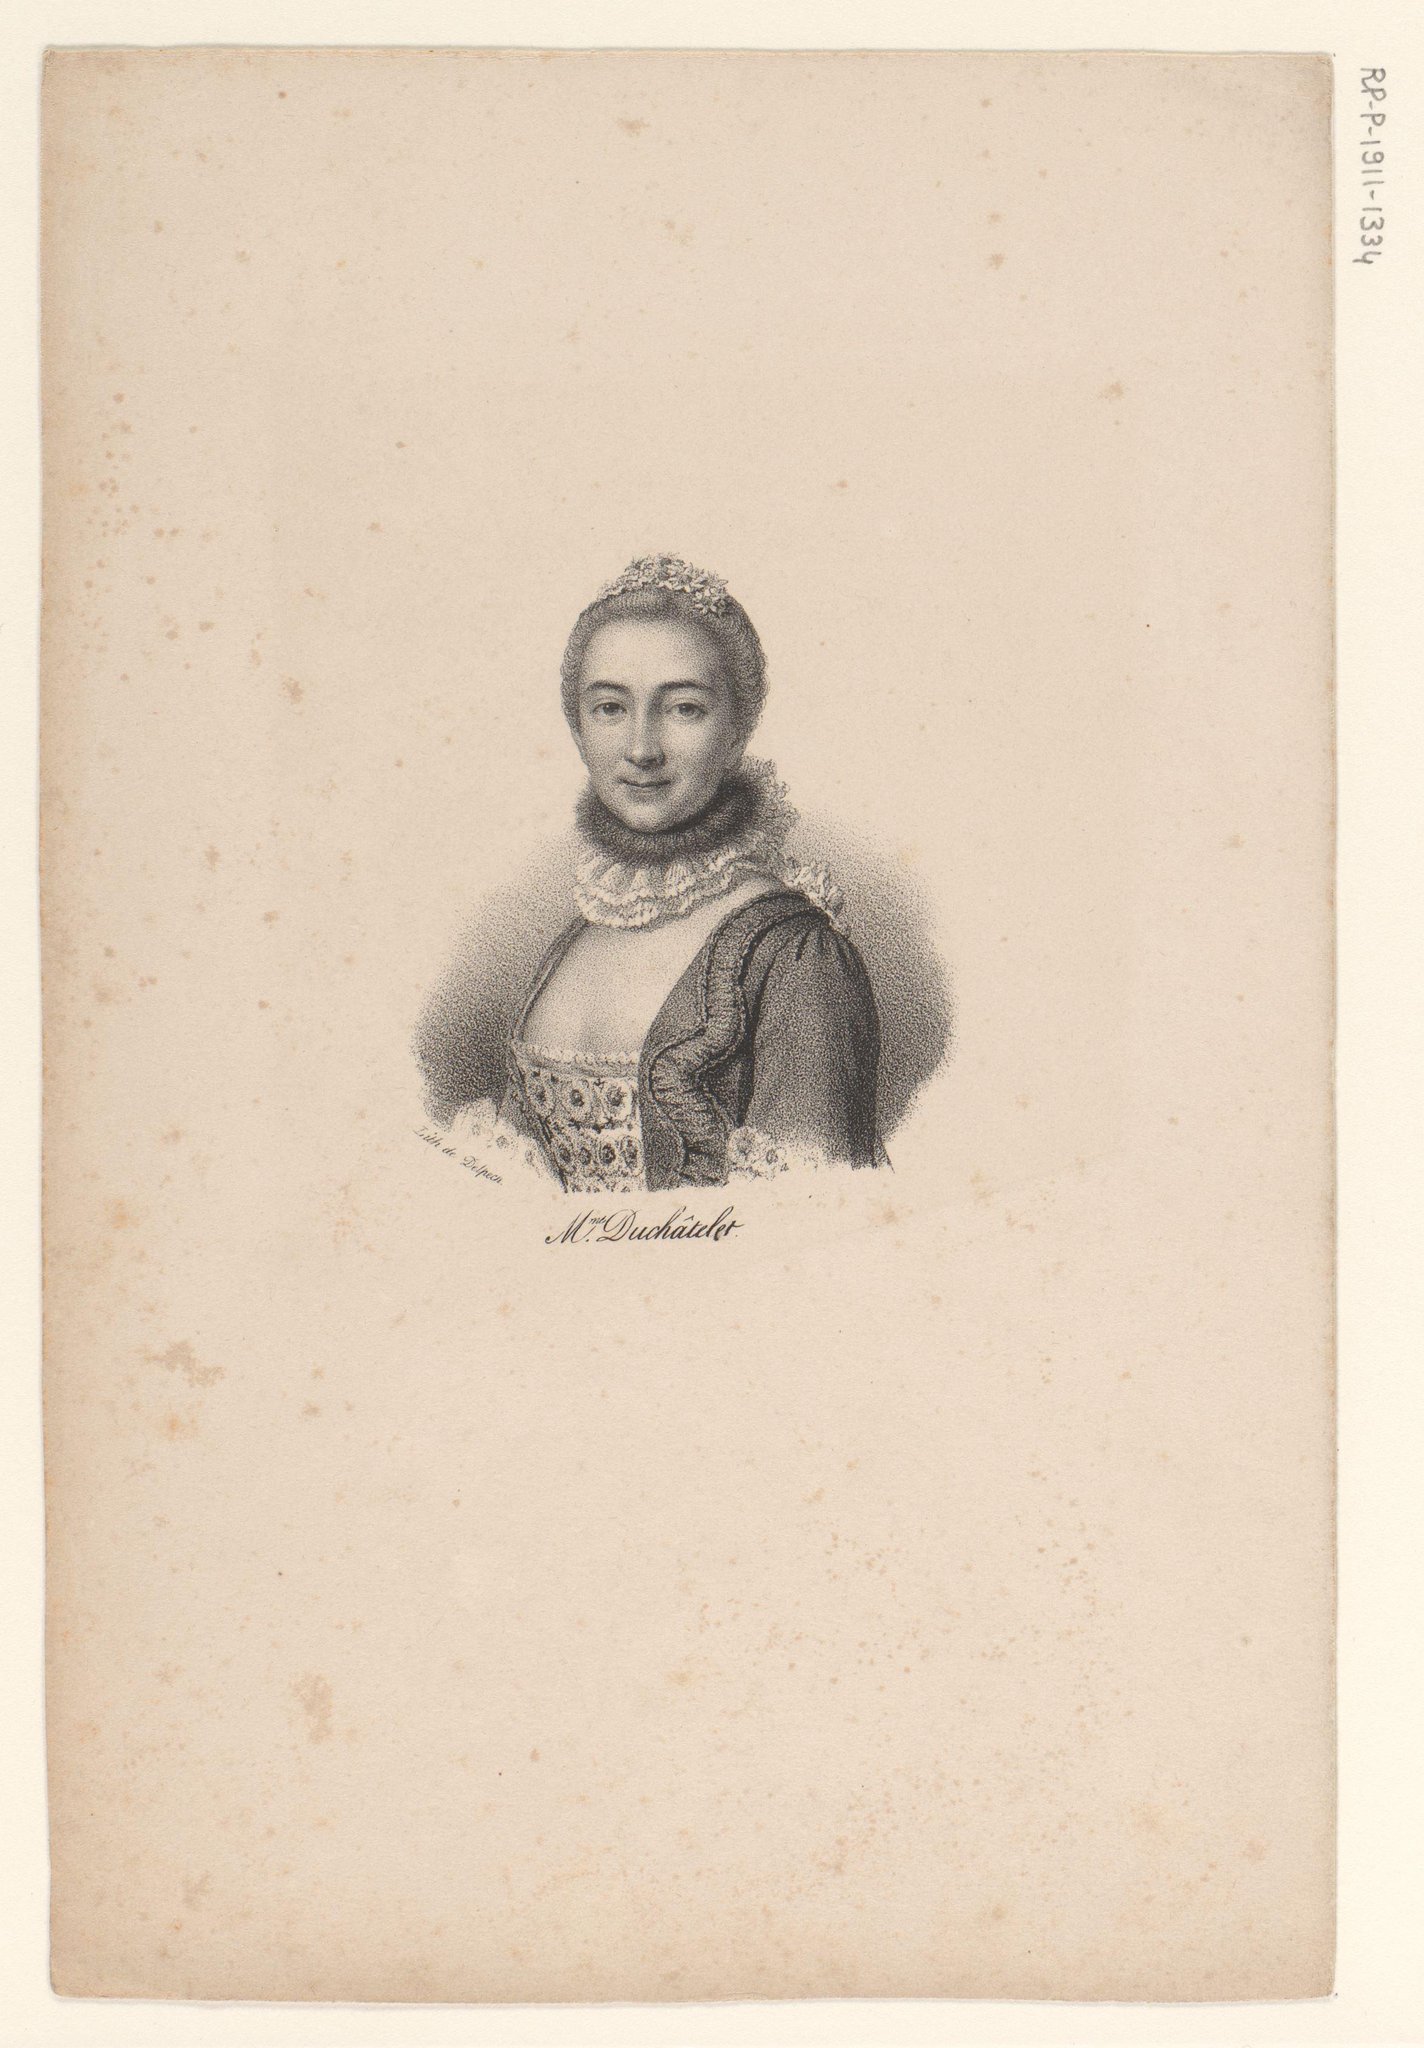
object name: print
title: M.me Duchâtelet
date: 1818-1842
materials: paper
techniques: lithograph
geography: paris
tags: physicist, historical persons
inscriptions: collector's mark: Lugt 2228a